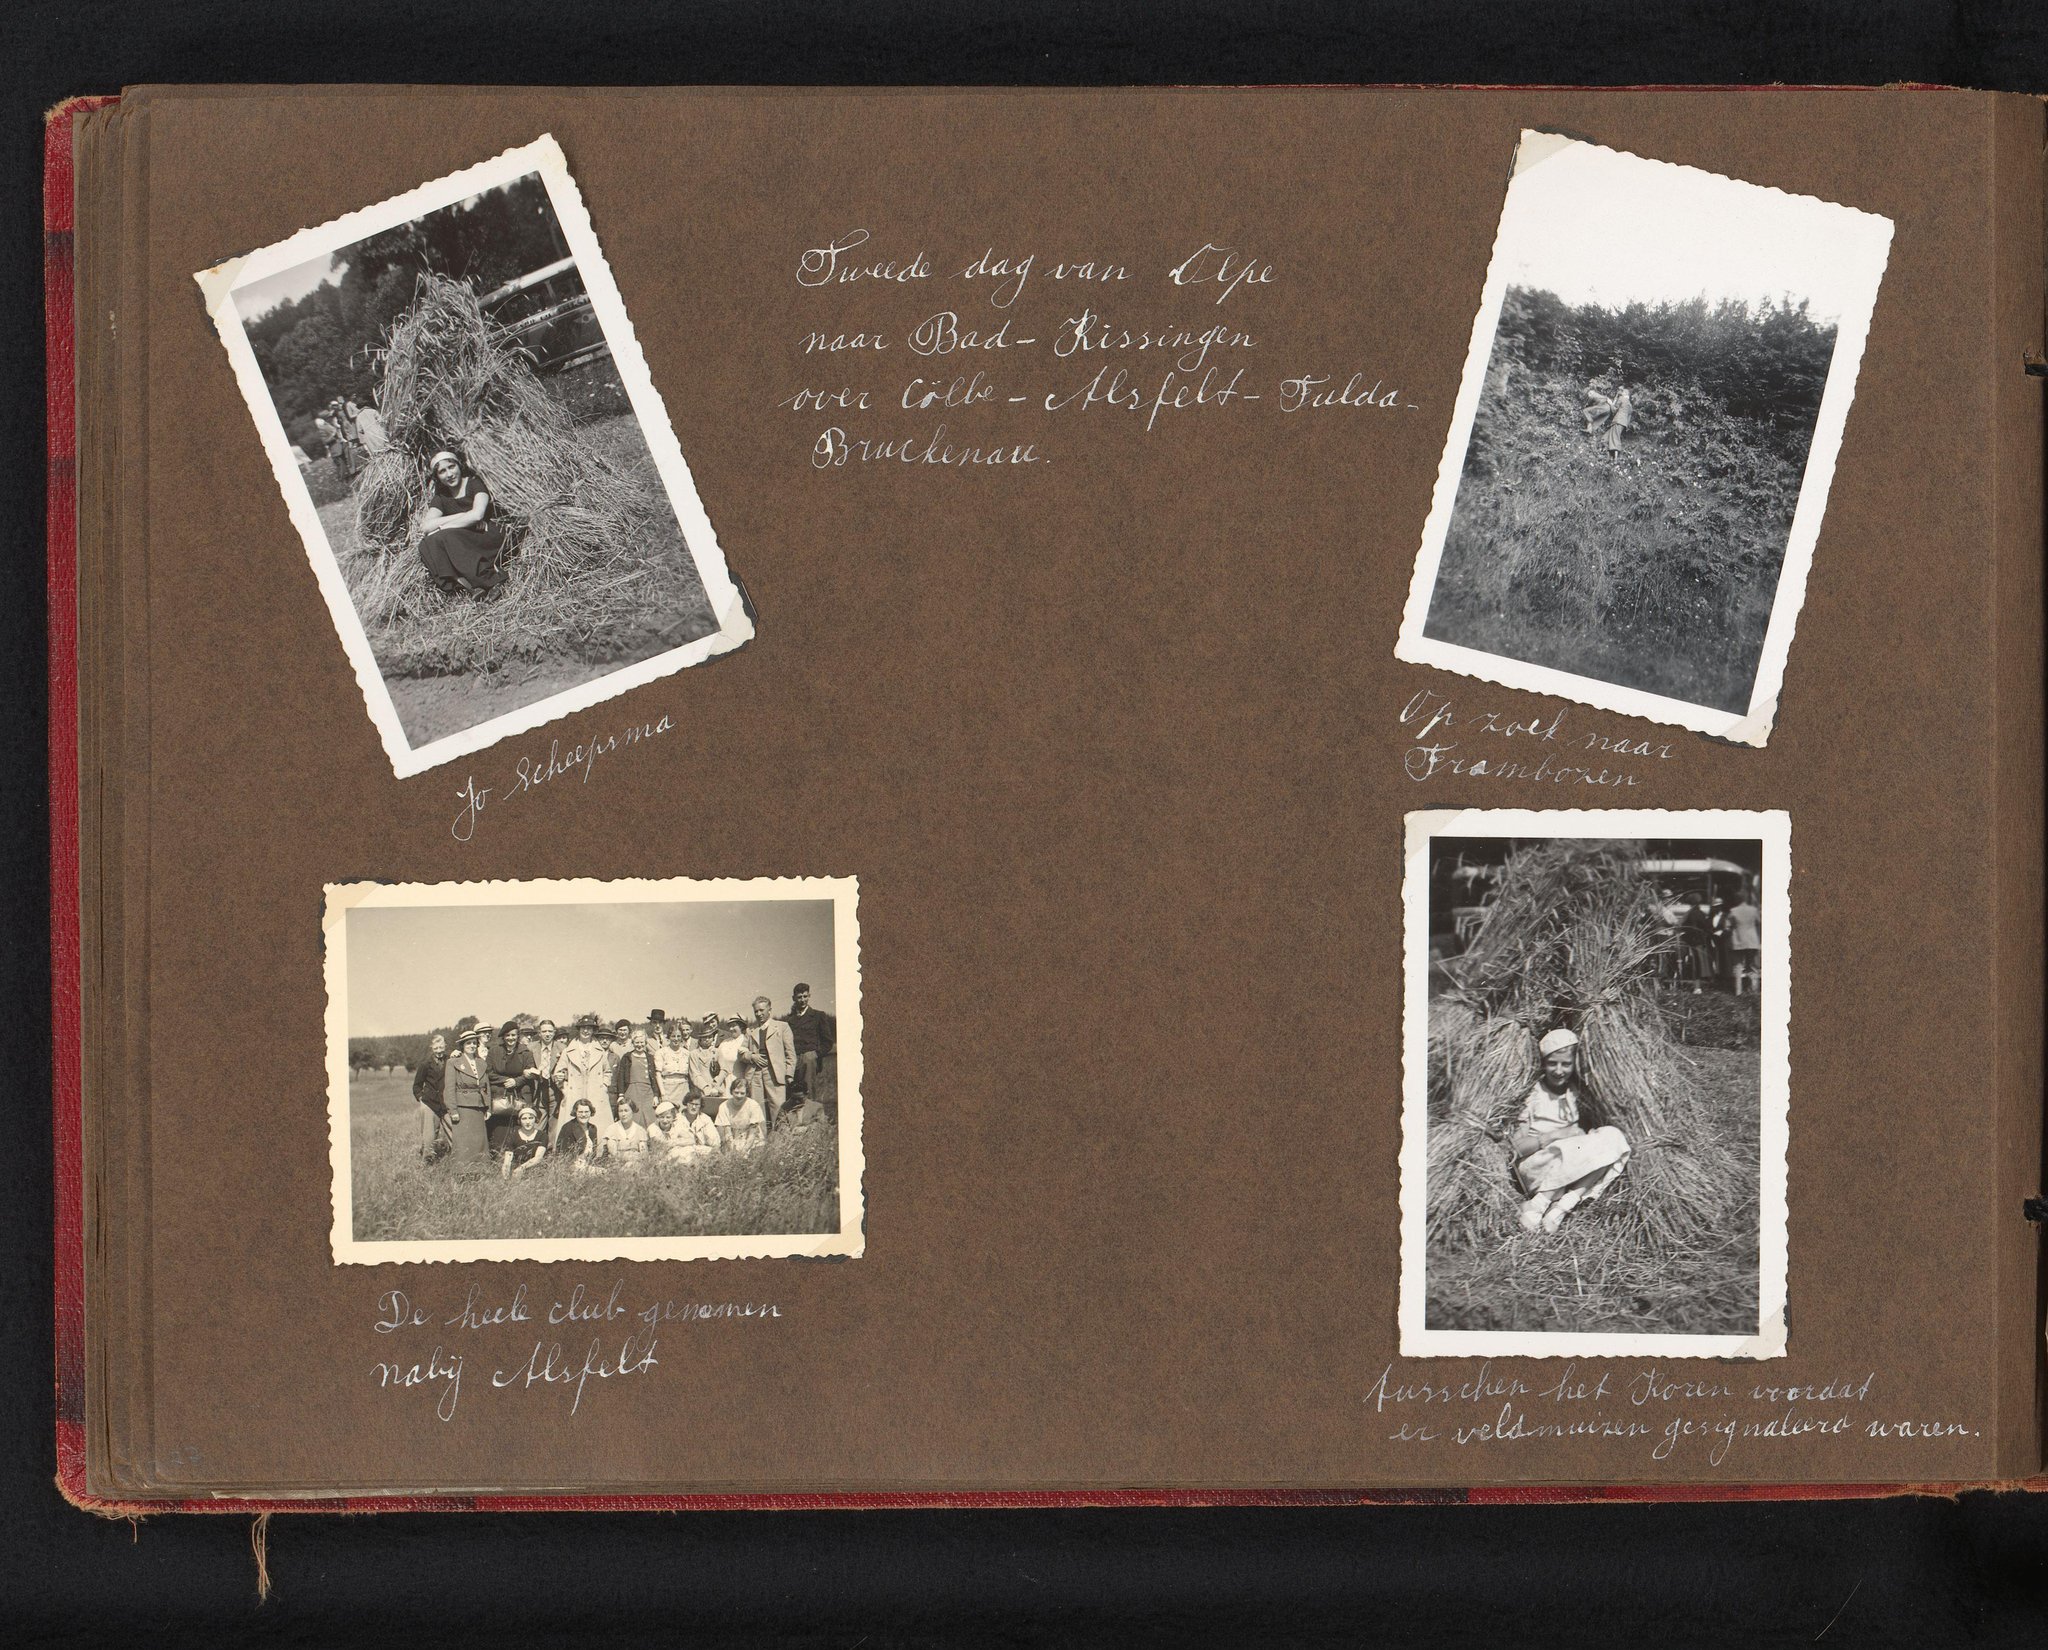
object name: photograph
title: Tweede dag van Olpe naar Bad-Kissingen over Cölbe-Alsfelt-Fulda-Bruckenau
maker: Anonymous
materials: paper, photographic support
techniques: gelatin silver print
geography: germany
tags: outing, pleasure trip, germany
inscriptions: inscription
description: Albumblad met vier foto's van de reis door Duitsland, groepsportret van het reisgezelschap en van dames tussen de korenschoven. Verslag van een twaalfdaagse groepsreis per autobus naar Salzburgerland en Beieren van 30 juli tot 10 augustus 1936. Onderdeel van het reisalbum van de familie Van den Broek 1935-1937.